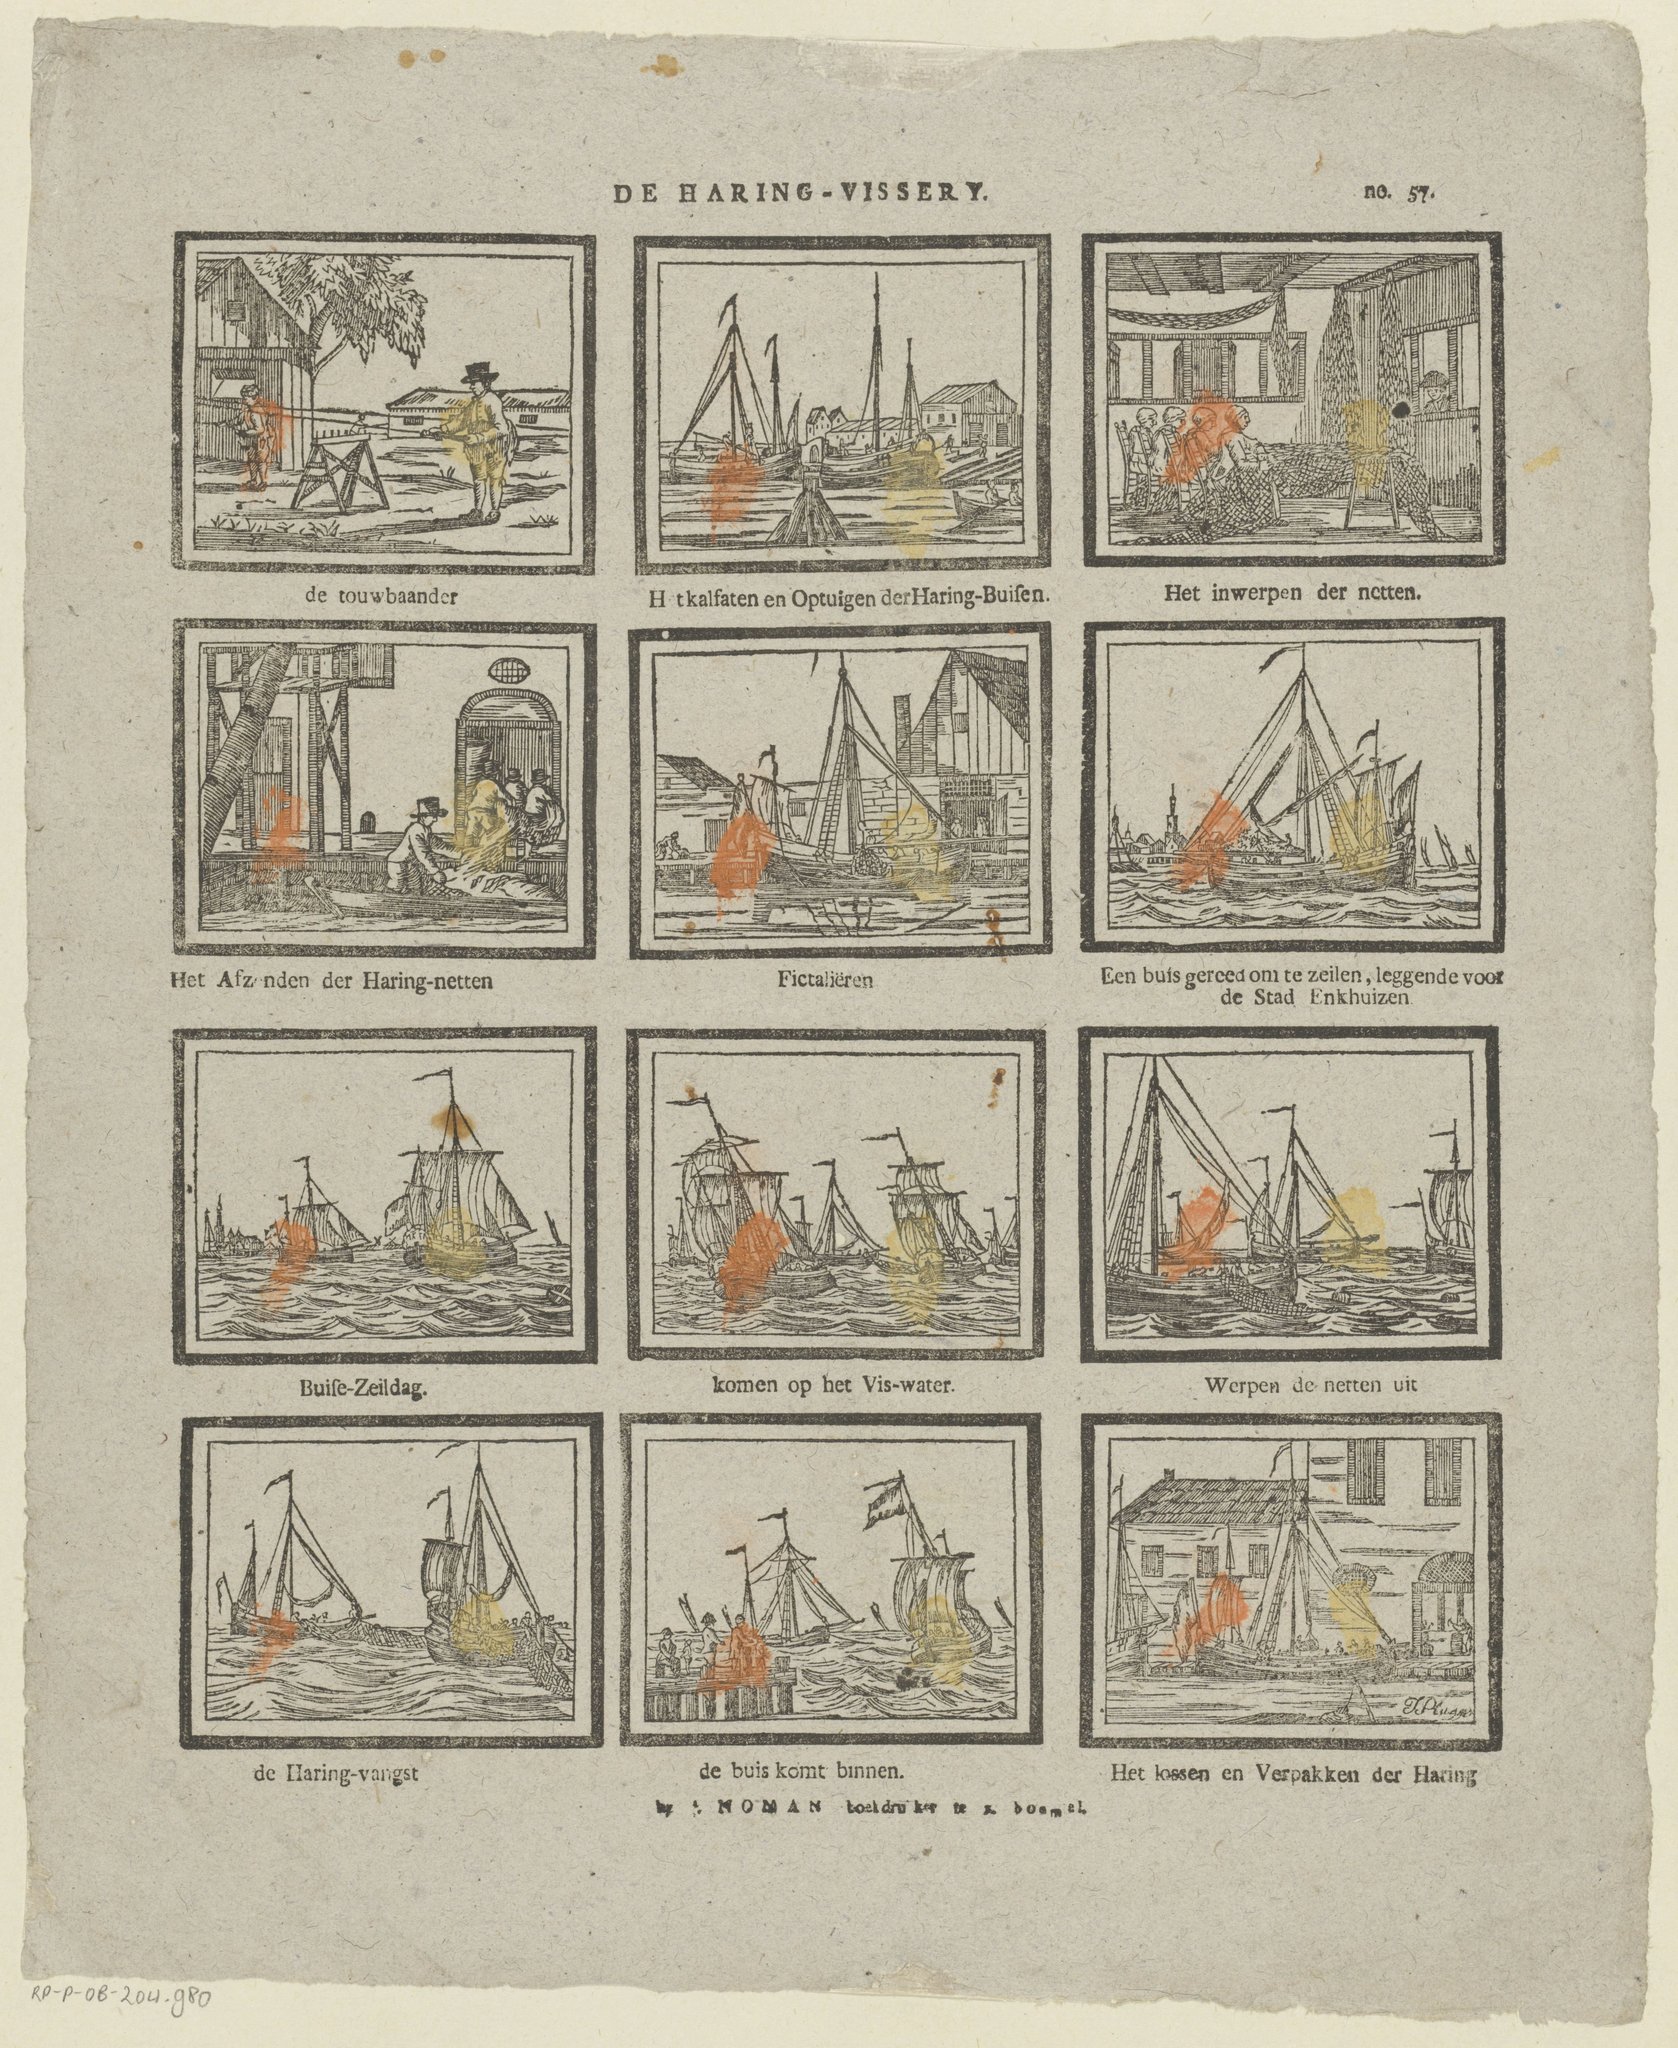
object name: popular print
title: De haring-vissery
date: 1806-1830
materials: paper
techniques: colour, letterpress printing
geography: netherlands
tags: herring fishery, ships (in general)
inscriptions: collector's mark: Lugt 2760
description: Blad met 12 voorstellingen van de haringvisserij. Onder elke afbeelding een onderschrift. Genummerd rechtsboven: no. 57.